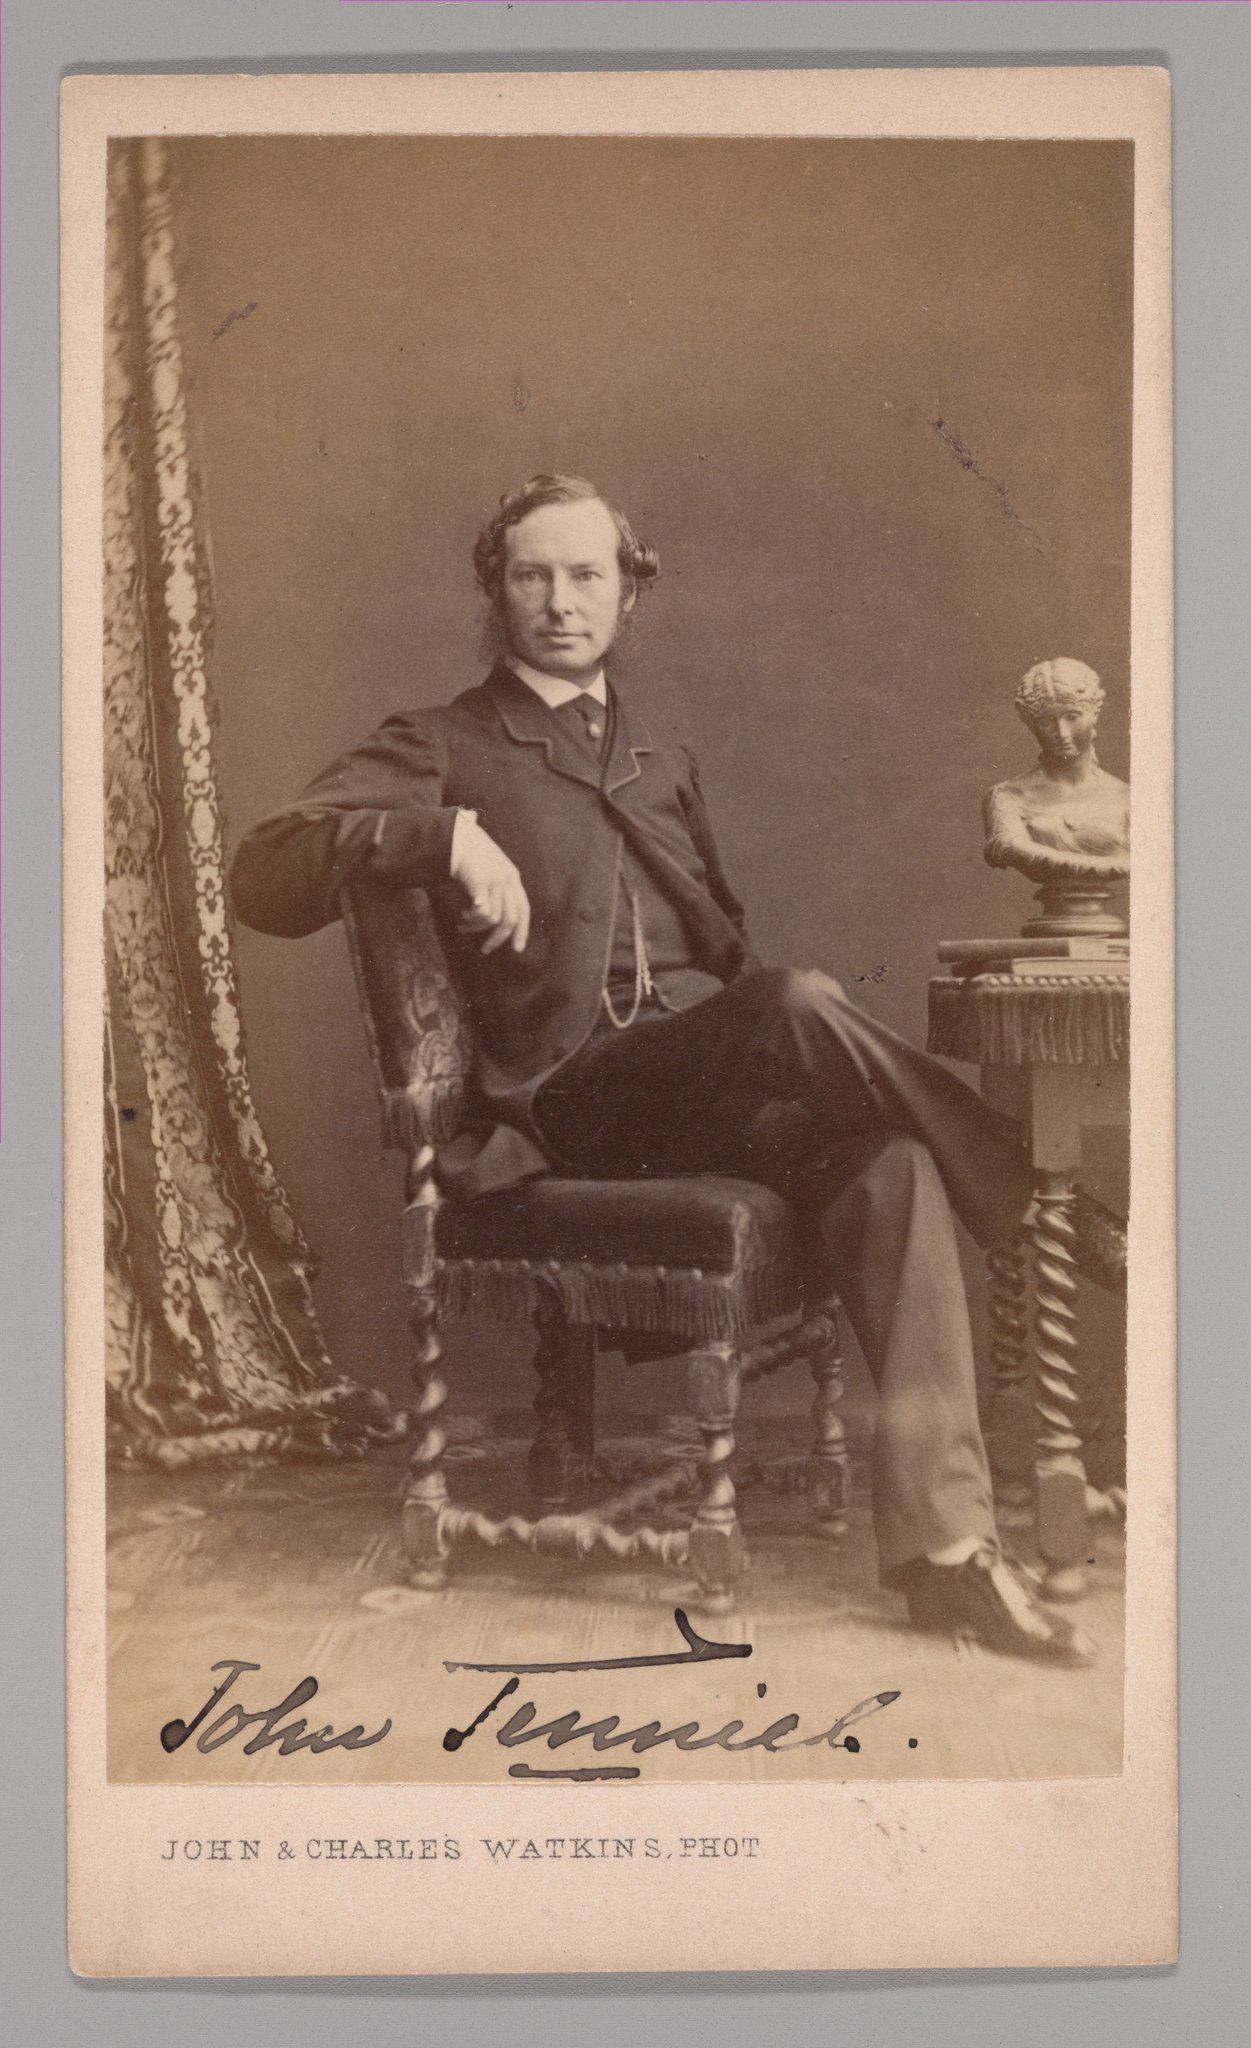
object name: carte de visite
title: [John Tenniel]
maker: john and charles watkins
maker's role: photography studio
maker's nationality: british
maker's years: 1840-1875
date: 1860-1869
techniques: albumen silver print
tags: men,portraits